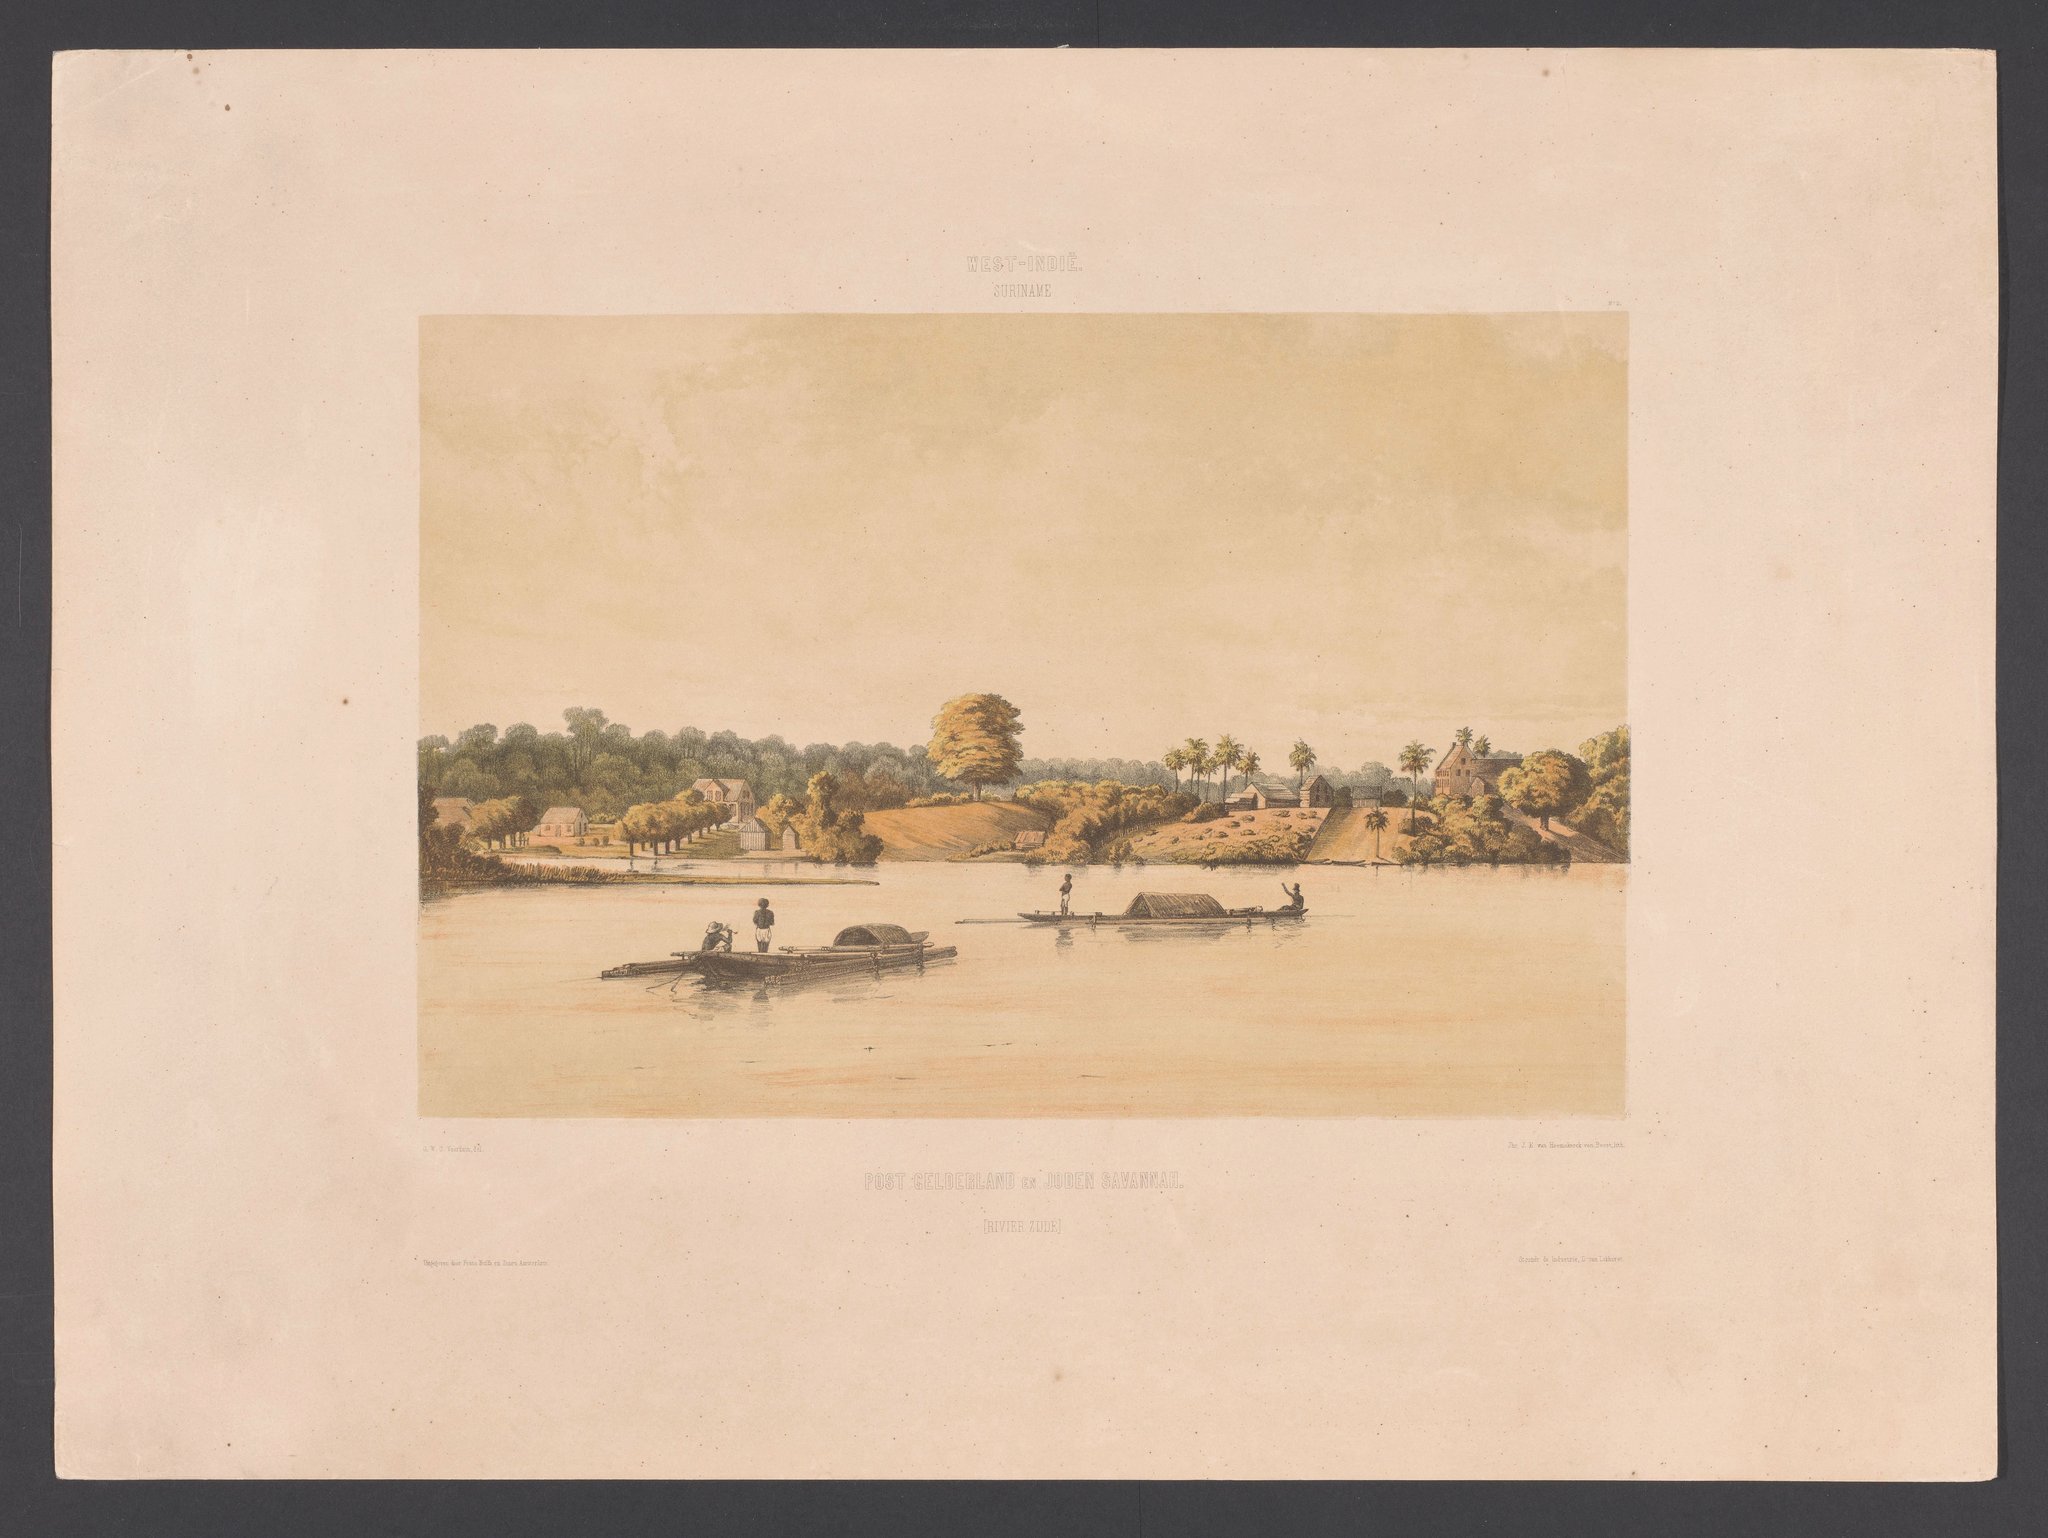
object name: print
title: Post Gelderland en Joden Savannah [rivierzijde]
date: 1860-1862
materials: paper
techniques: lithograph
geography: netherlands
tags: river, rowing-boat, canoe, etc., grasslands, savanna, prairie, suriname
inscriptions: collector's mark: Lugt 2760, collector's mark: Lugt 2228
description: Gezicht vanaf de Surinamerivier op de Jodensavanna en de militaire Post Gelderland. Op de rivier enkele vaartuigen. Prent maakt deel uit van een omslag met zeventien bladen.